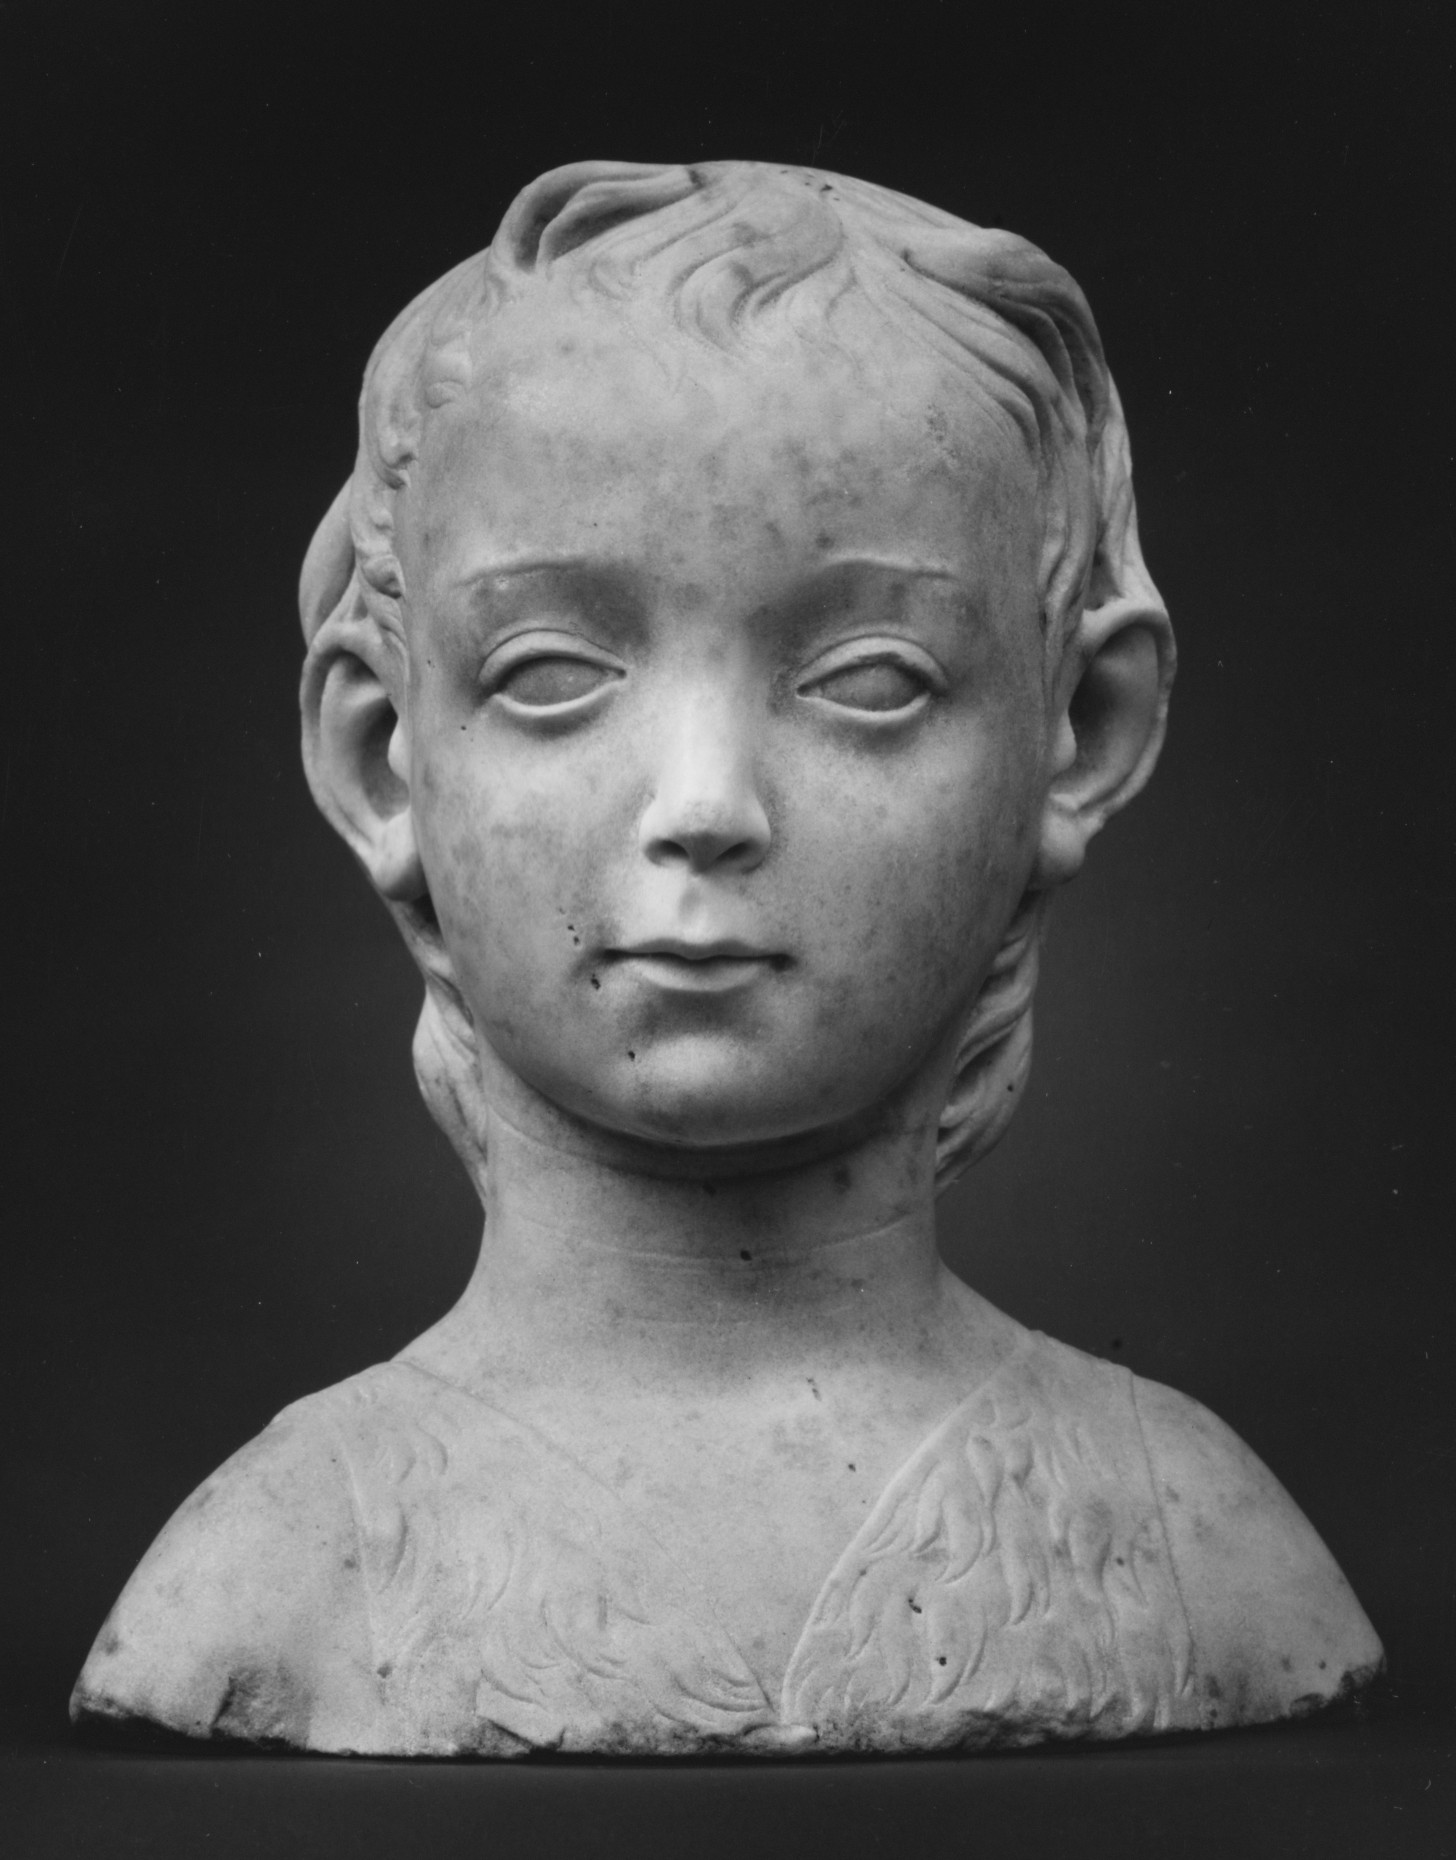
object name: bust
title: Saint John the Baptist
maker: antonio rossellino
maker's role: artist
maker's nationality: italian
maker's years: 1427-1479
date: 1475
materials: marble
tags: saint john the baptist